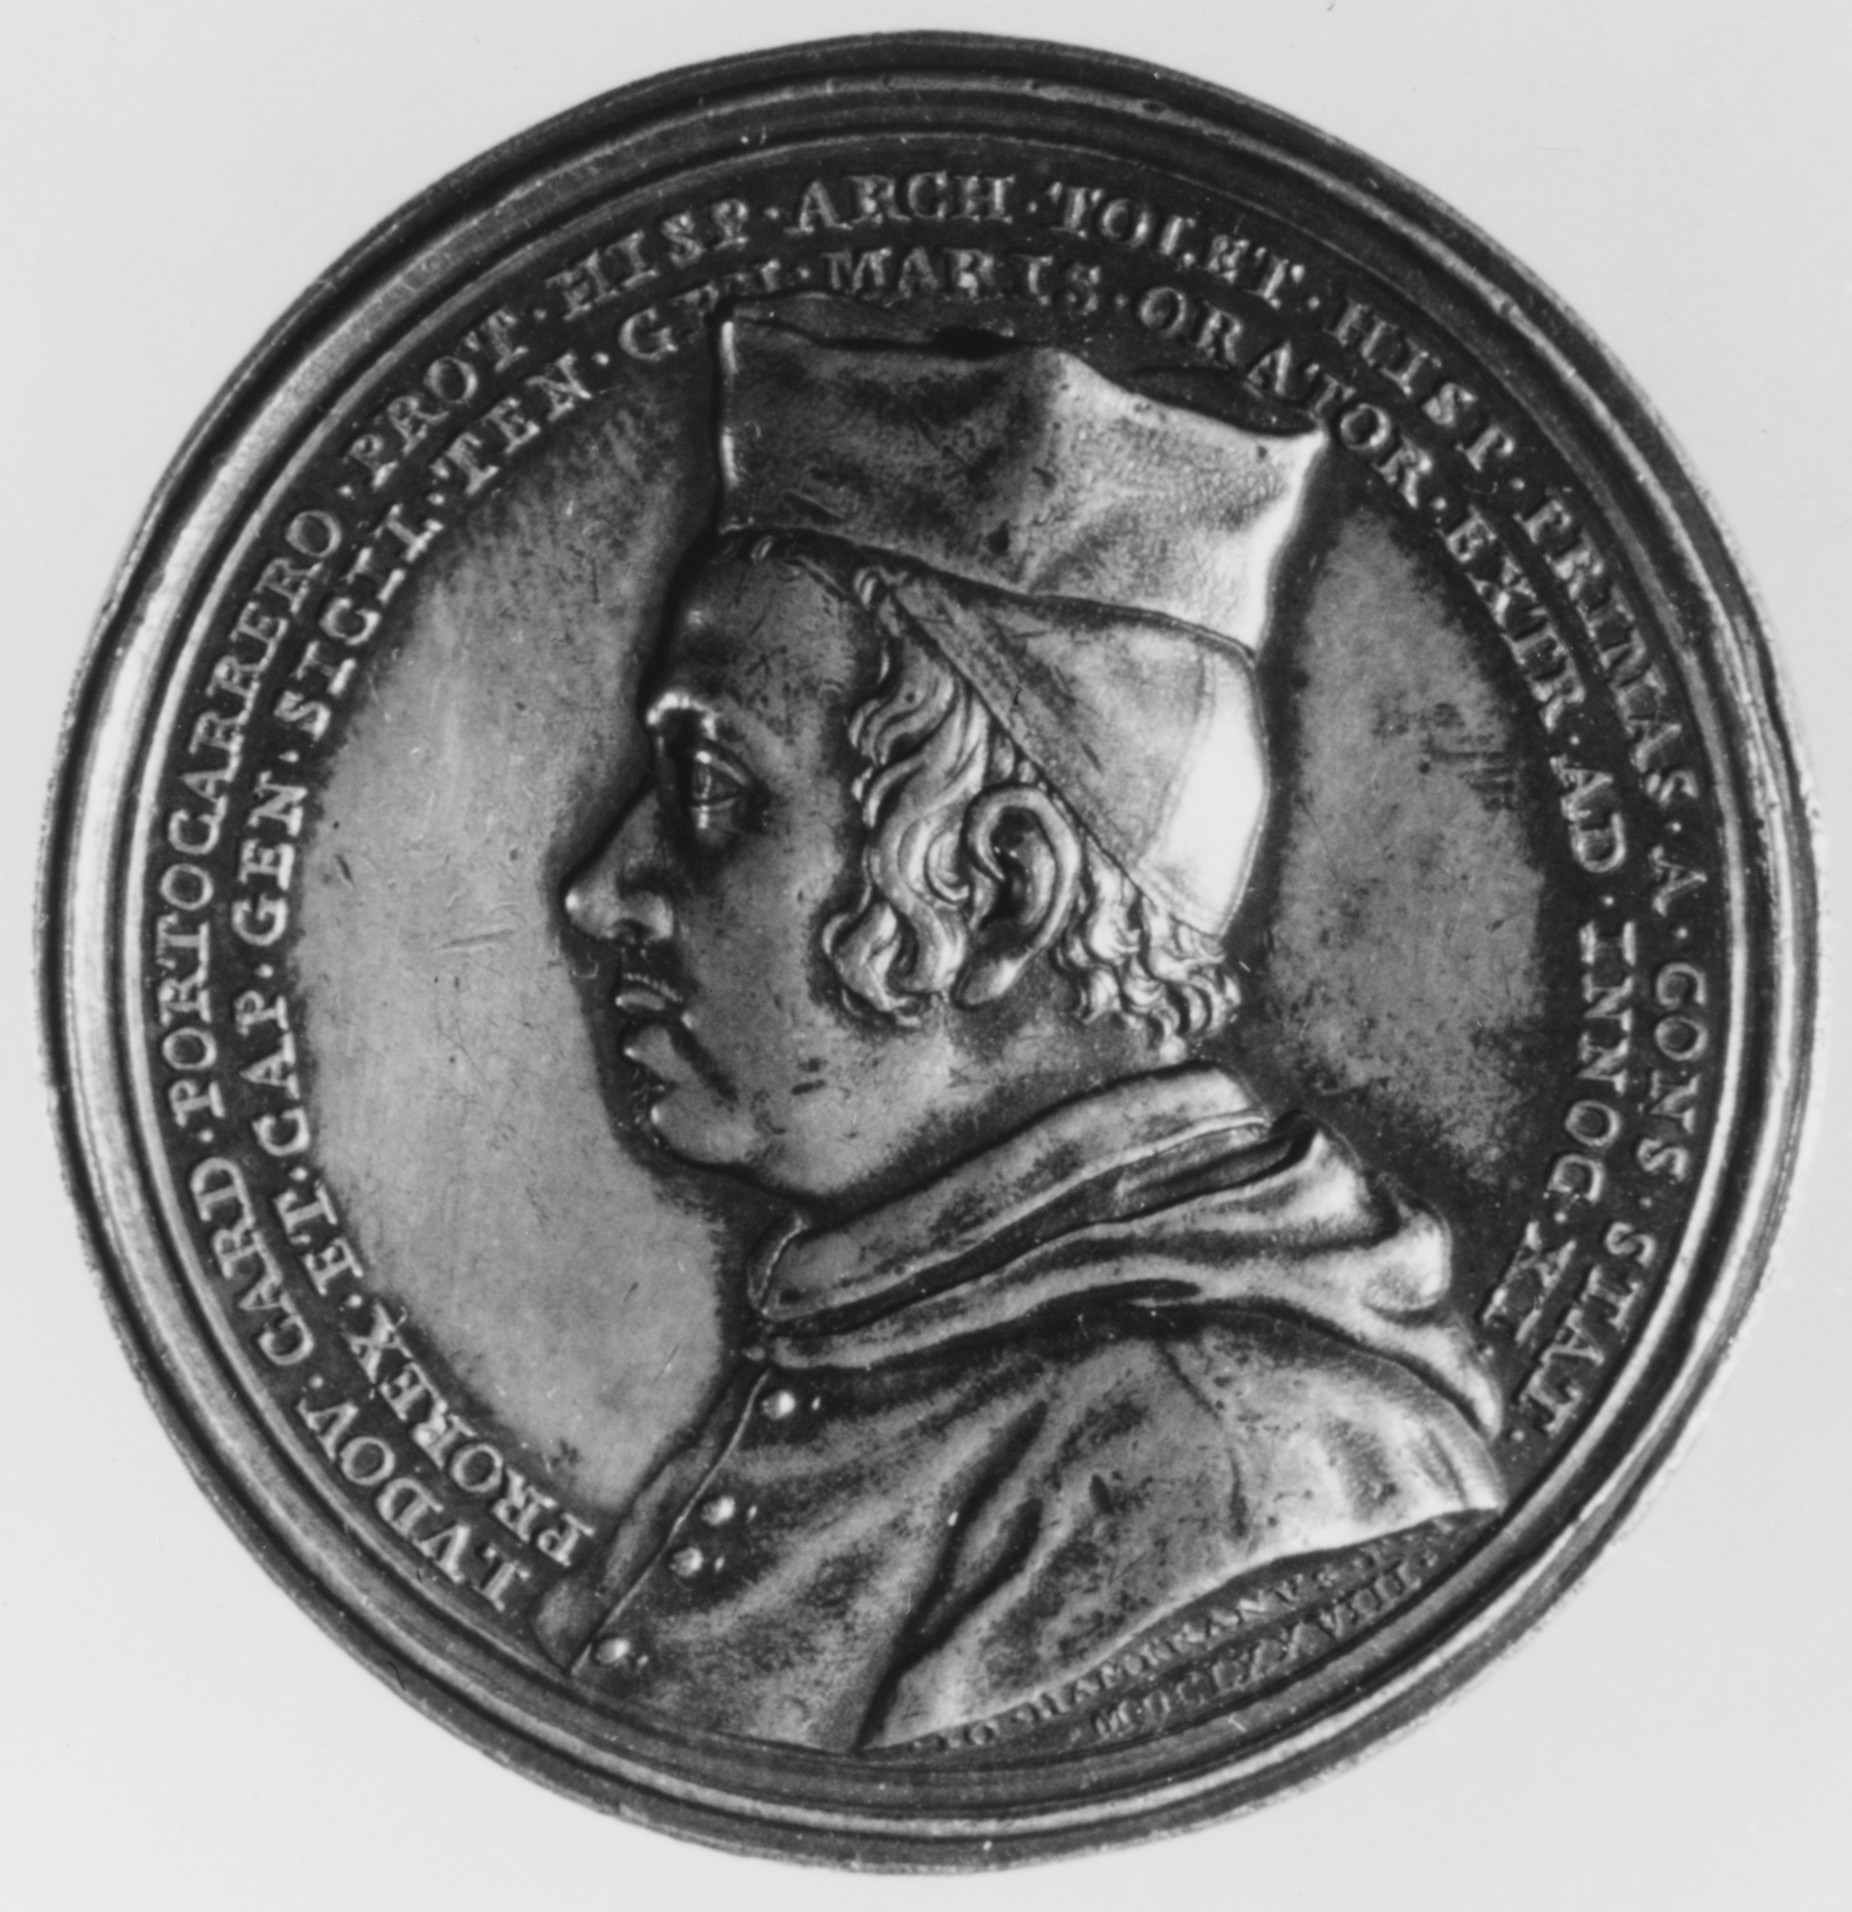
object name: medal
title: Luis, Cardinal de Portocarrero, Spanish Statesman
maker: giovanni martino hamerani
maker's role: artist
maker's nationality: italian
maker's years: 1646-1705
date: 1678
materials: silver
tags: men,profiles